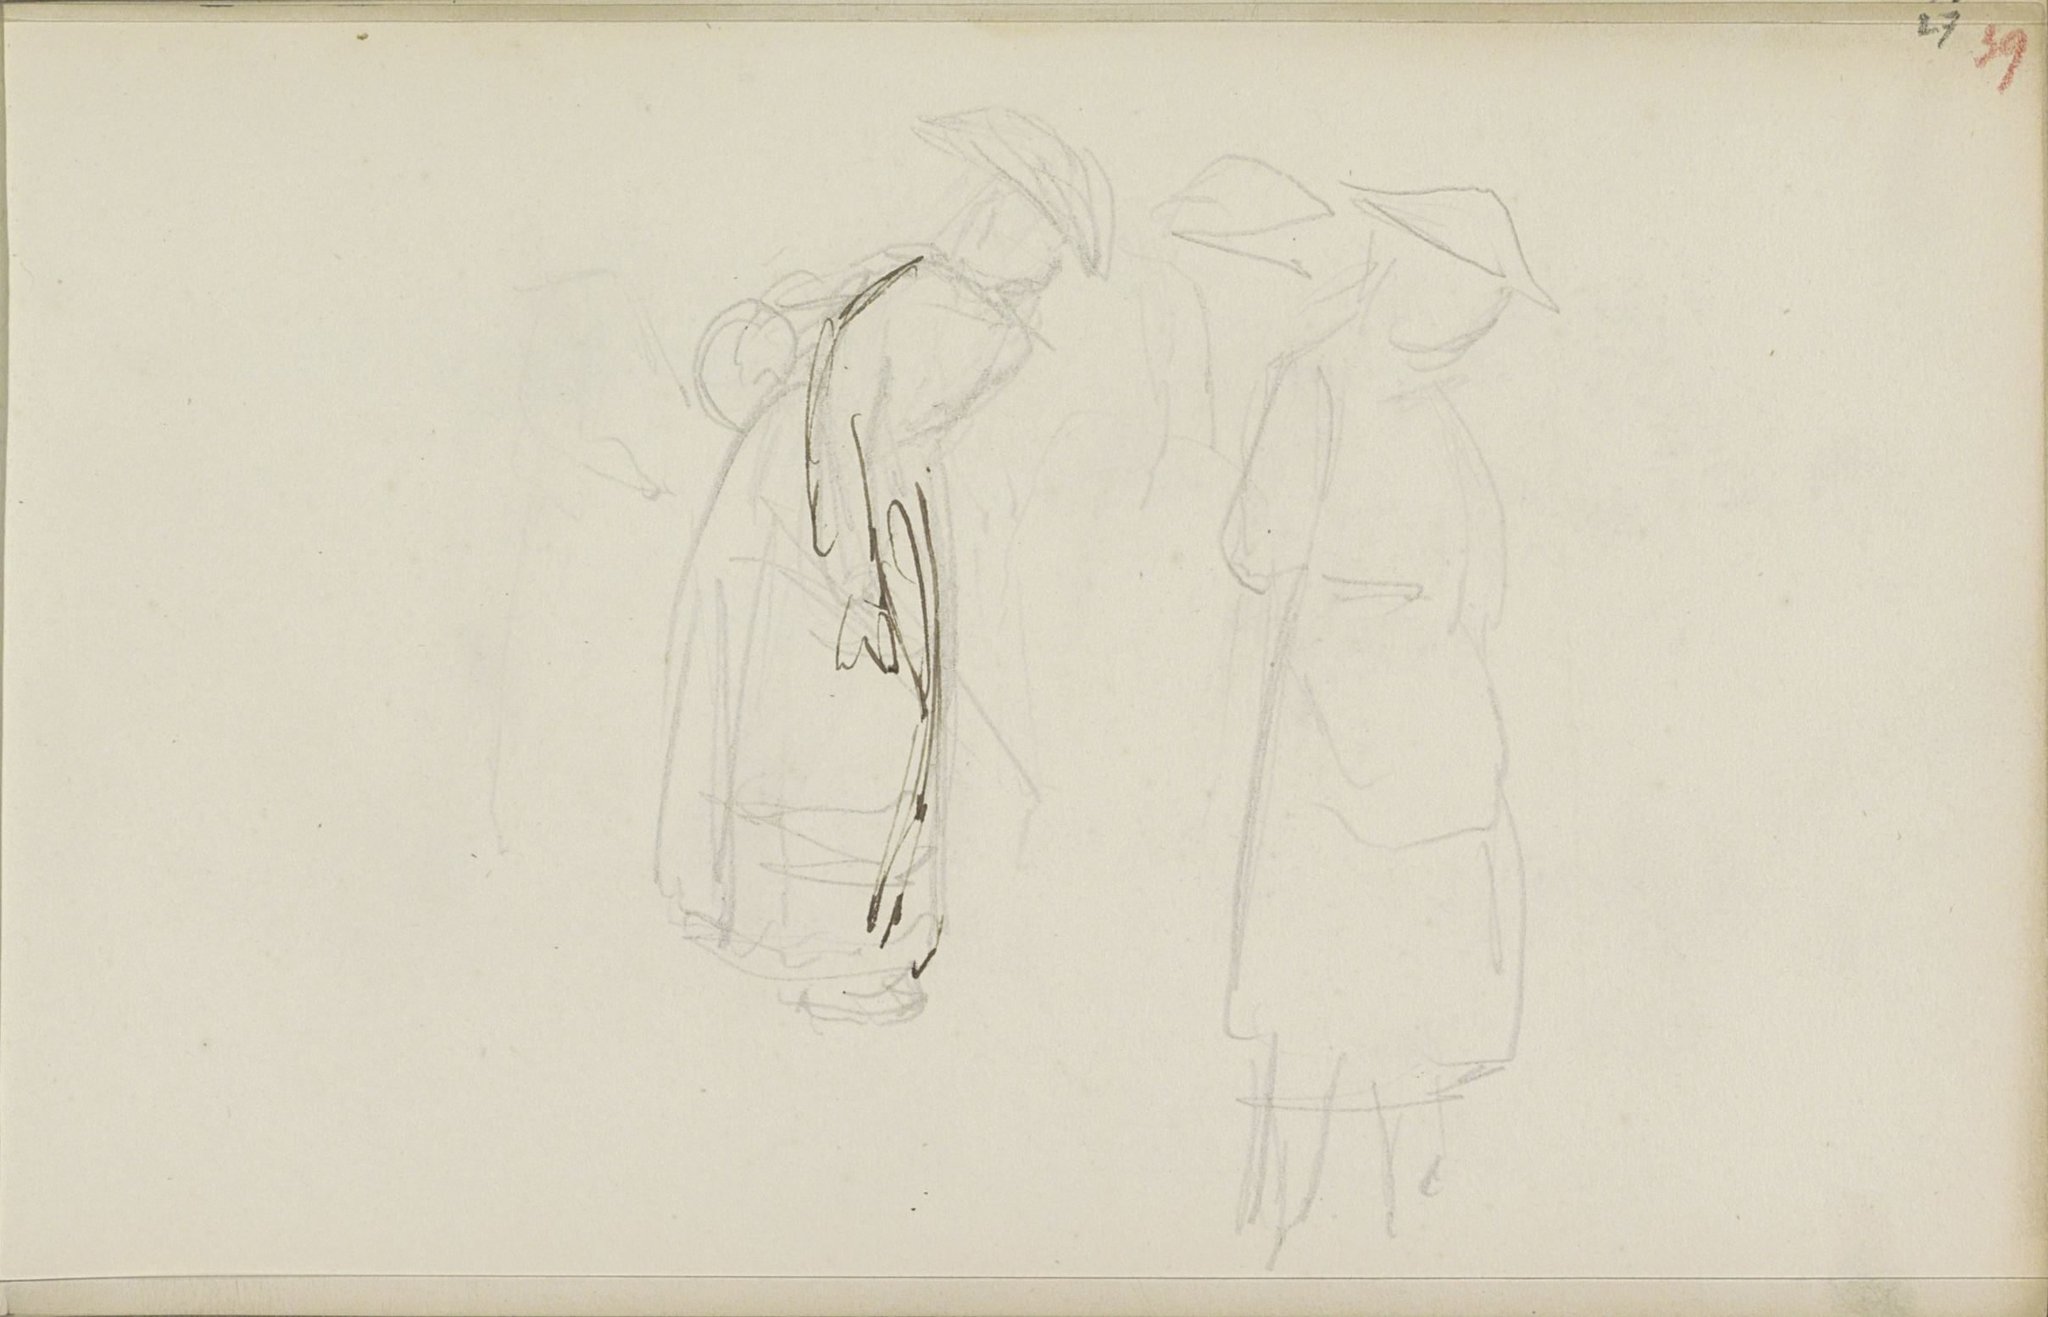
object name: sketchbook leaf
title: Twee vrouwen met hoeden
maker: jozef israëls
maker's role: draughtsman, painter, print maker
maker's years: 1824-1911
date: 1834-1911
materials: ink, paper, pencil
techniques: pen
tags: adult woman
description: Blad 27 recto uit een schetsboek met 37 bladen.